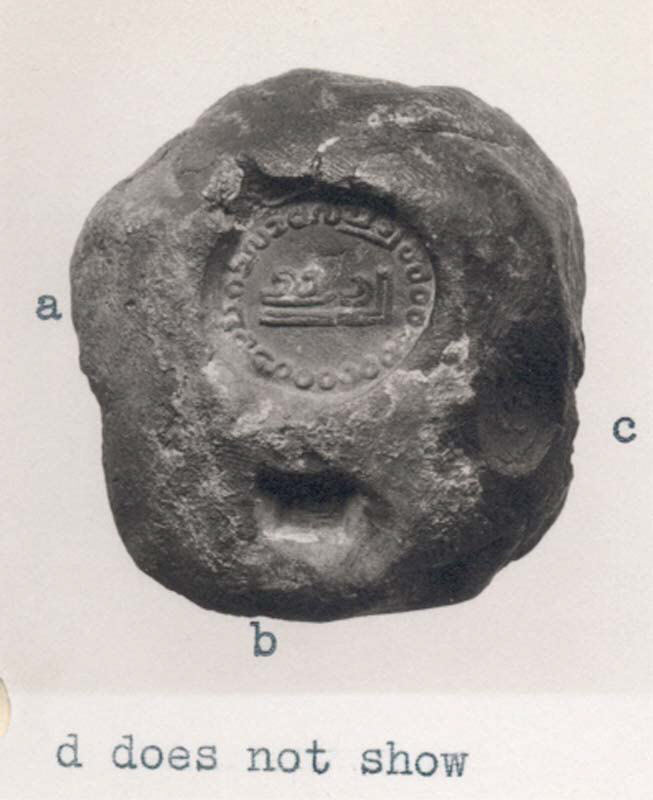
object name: sealing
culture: sasanian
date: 601-700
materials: clay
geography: iran